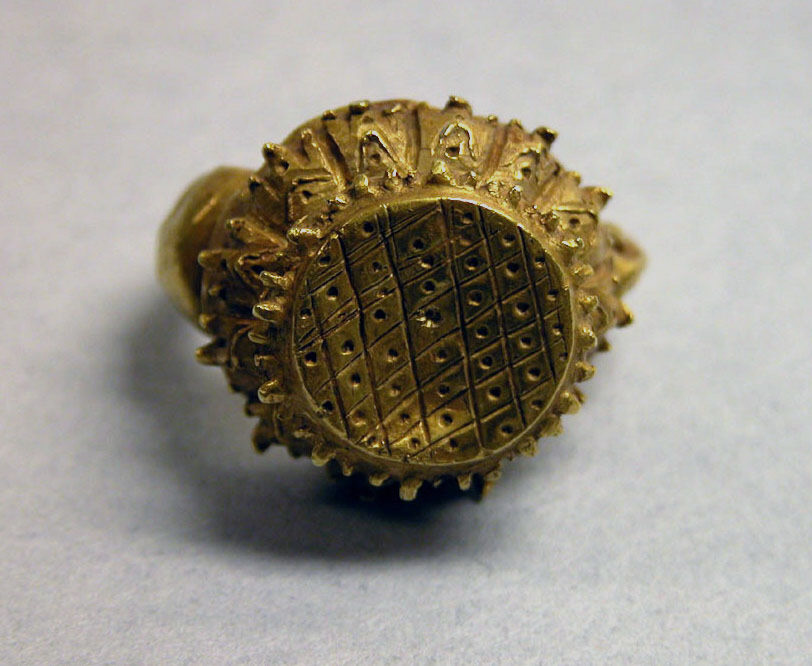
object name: ring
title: Stirrup-shaped Ring with Bezel with Diaper Design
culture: indonesian, javanese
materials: gold